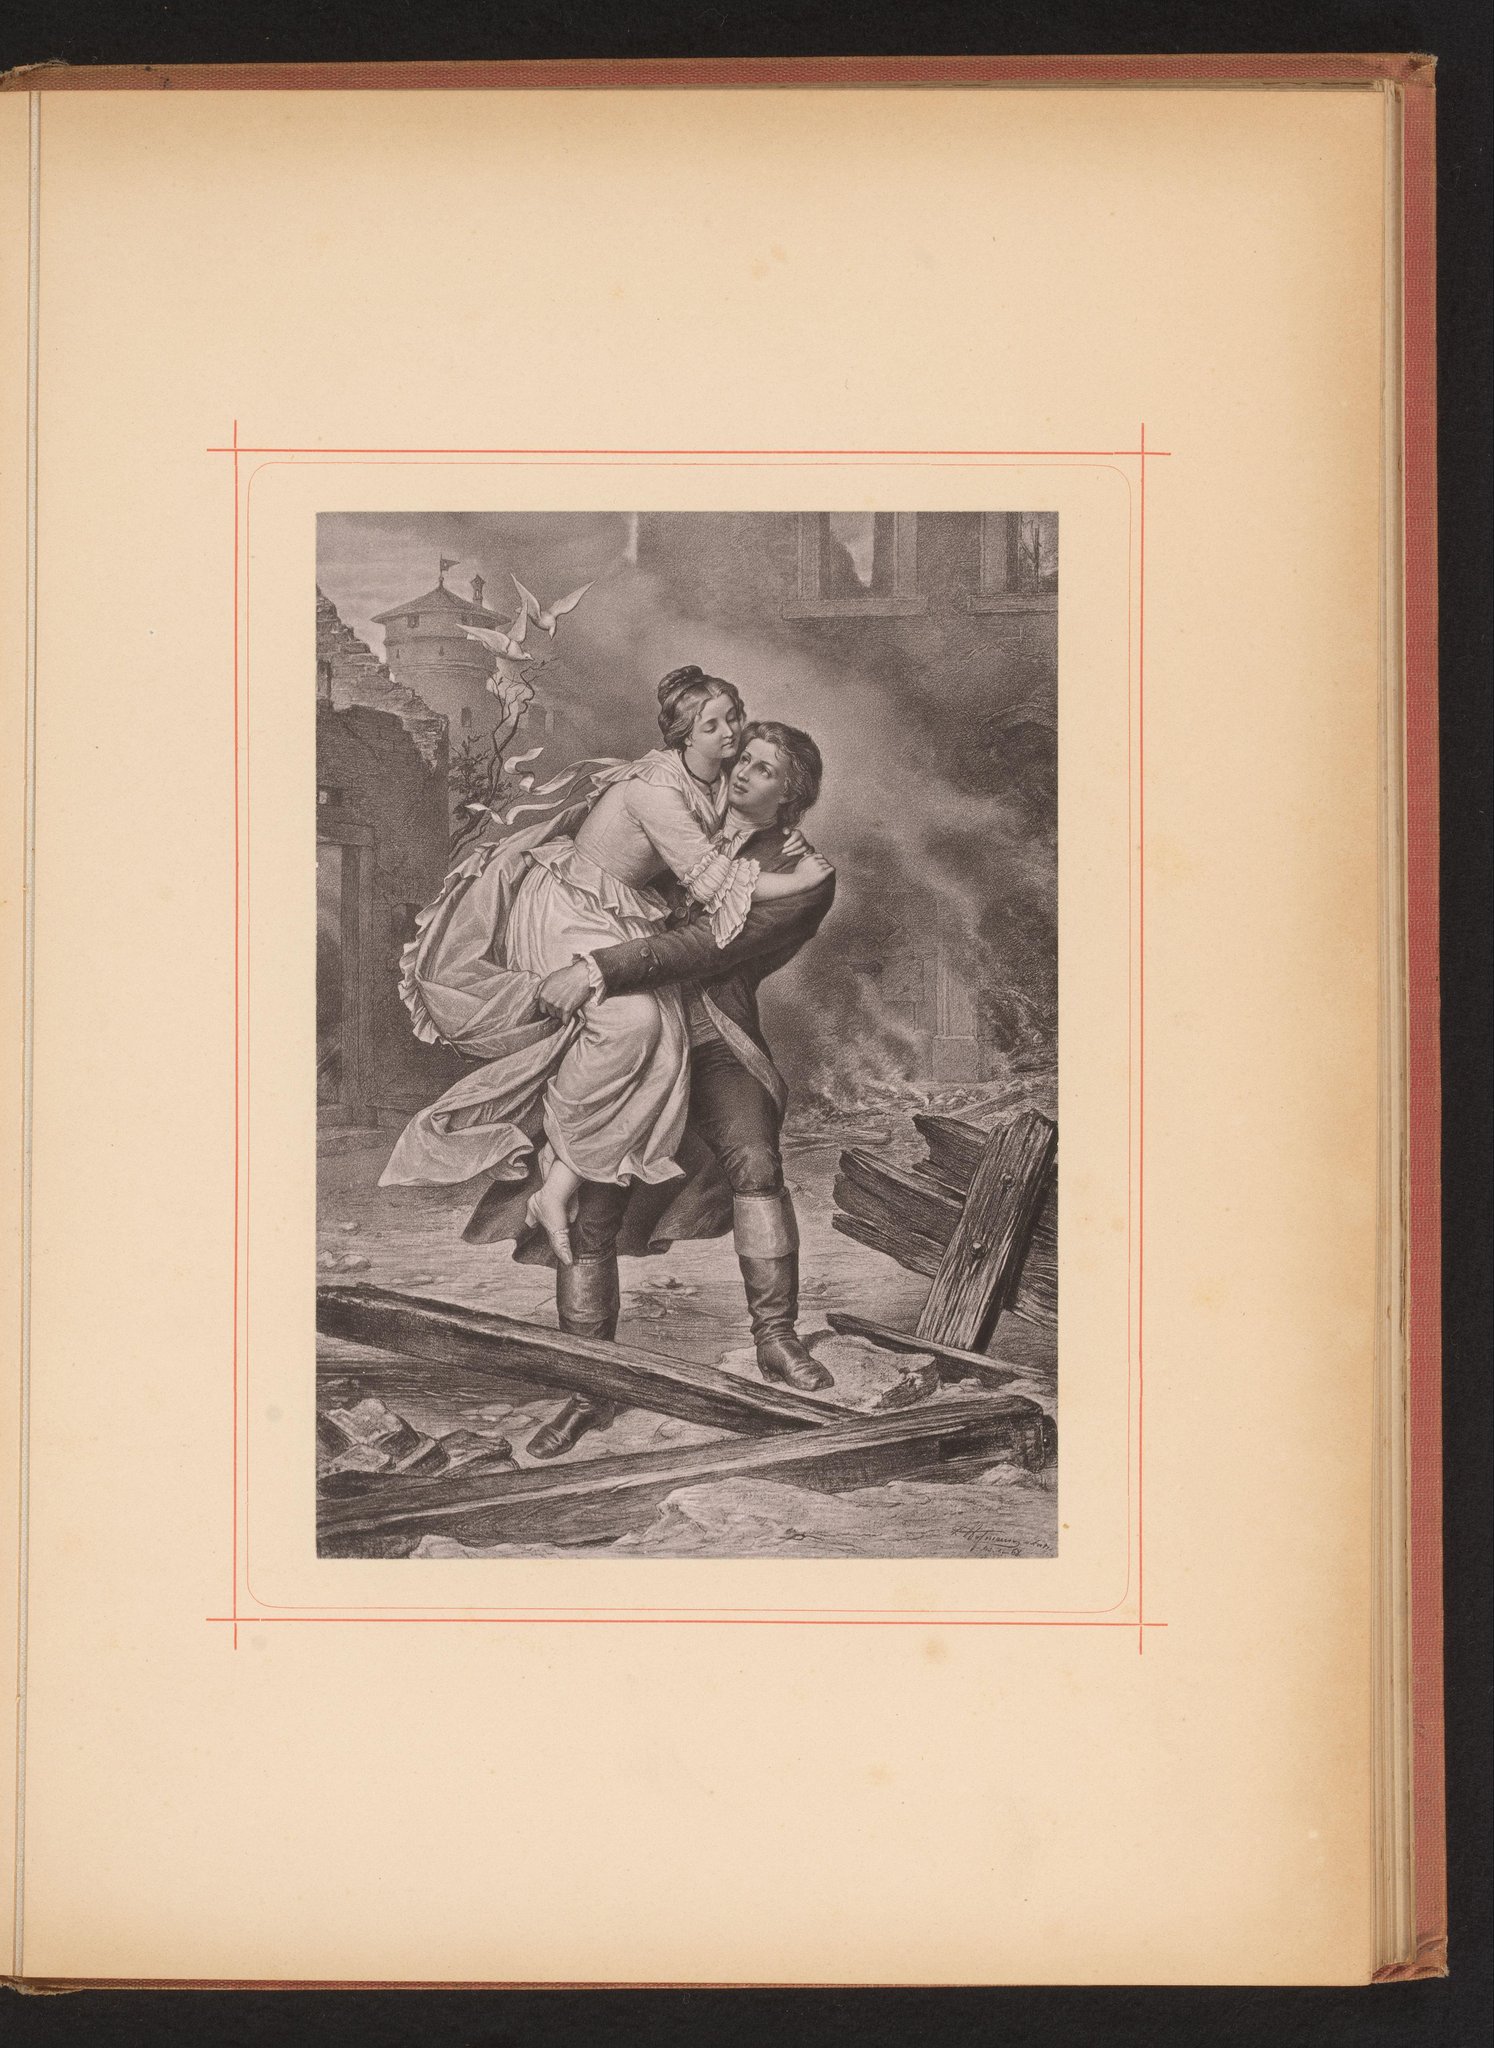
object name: page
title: Reproductie van een tekening, voorstellende Hermann draagt Dorothea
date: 1880-1885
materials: paper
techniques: photograph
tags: adolescent, young woman, maiden, carrying a person, youth, adolescent, literary characters and objects, painting, drawing and the graphic arts